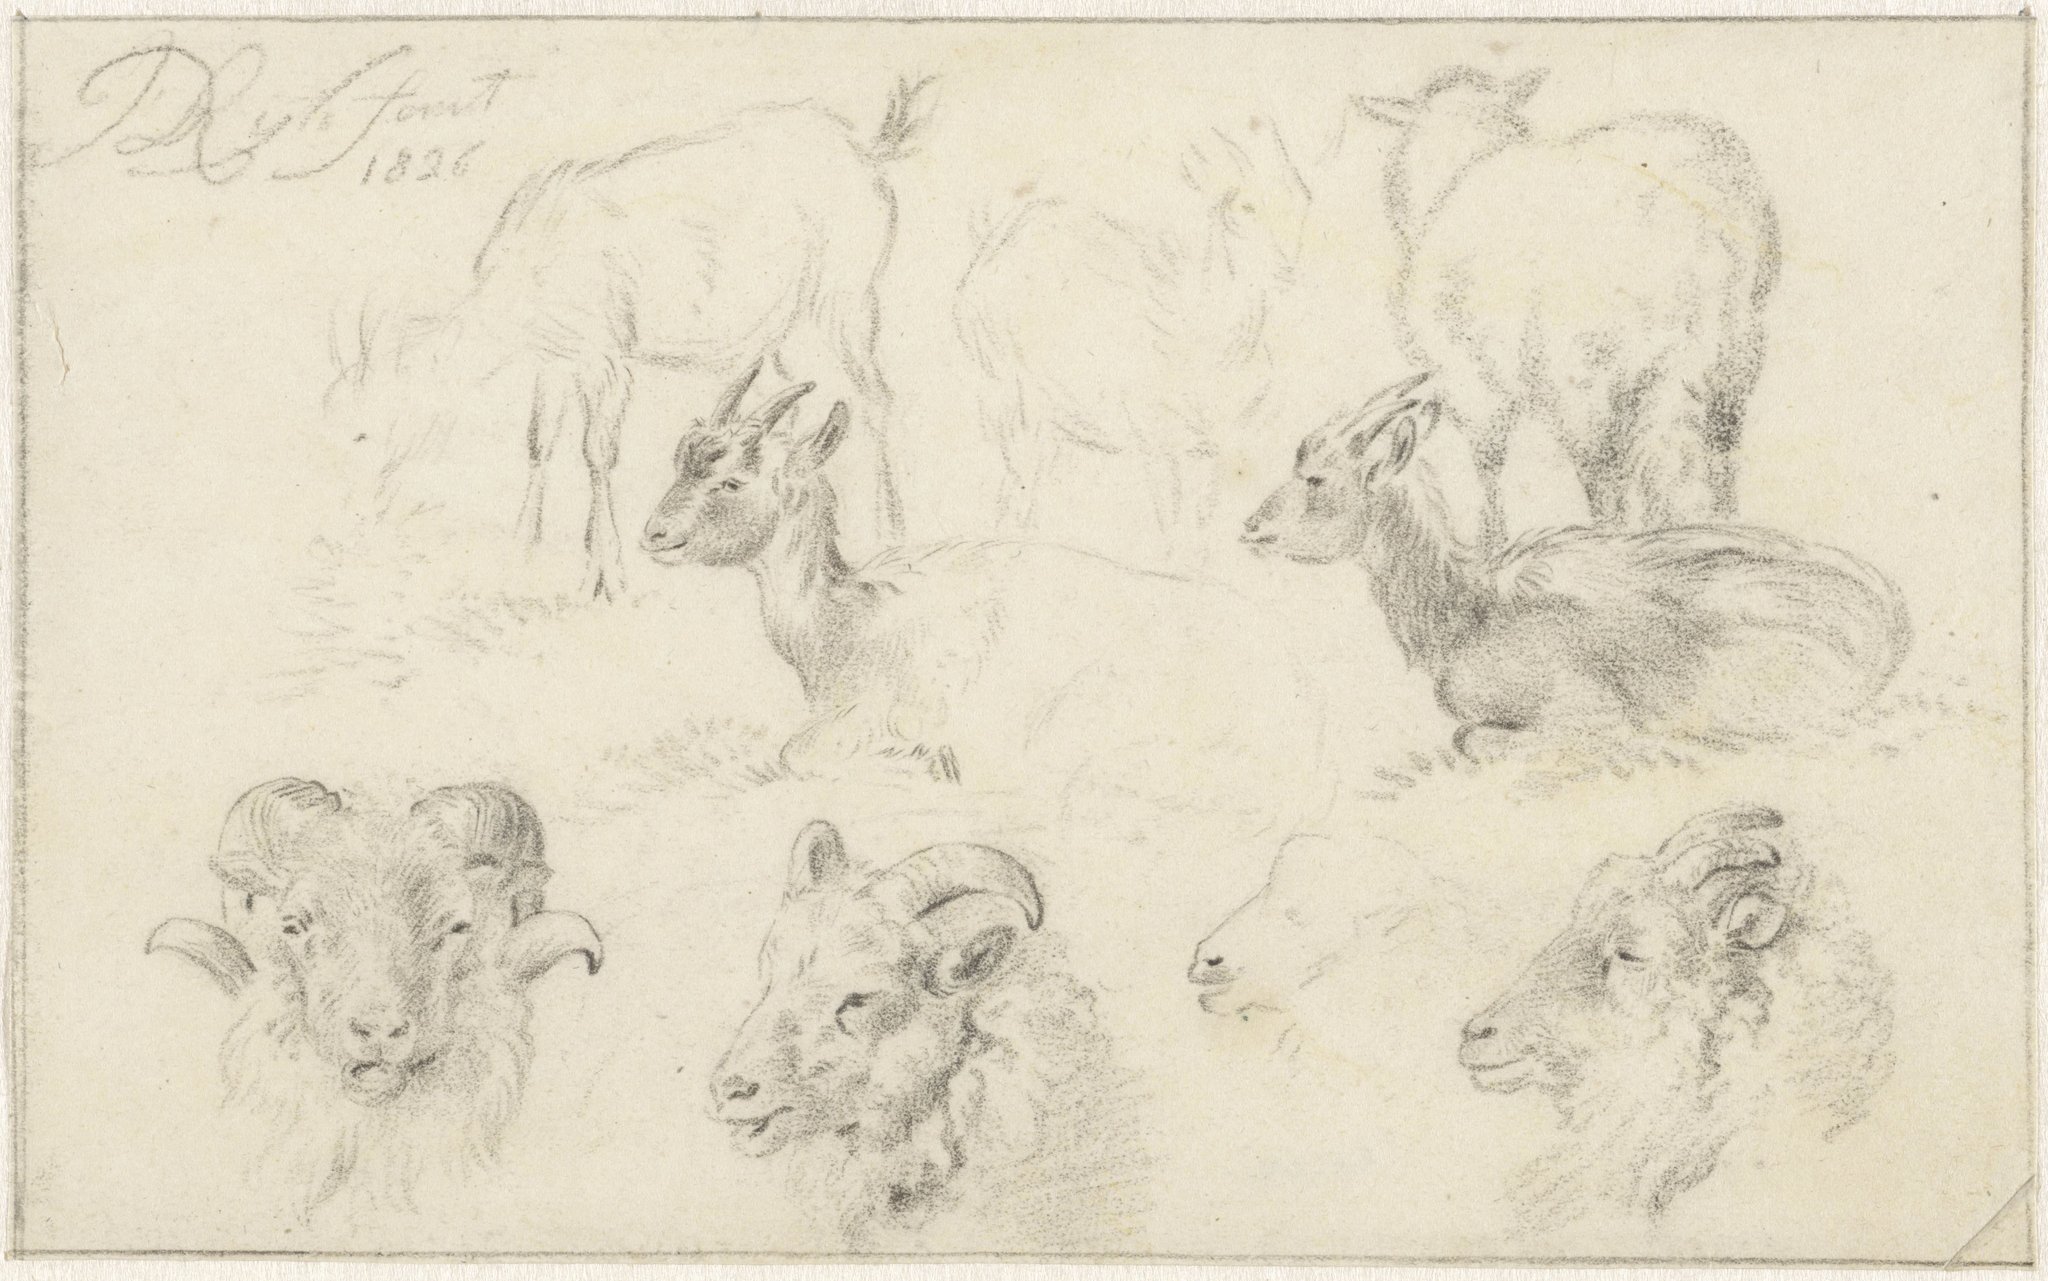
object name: drawing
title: Studies van schapen en geiten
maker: james de rijk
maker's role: draughtsman, painter, print maker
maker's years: 1806-1882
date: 1826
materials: chalk, paper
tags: sheep, goat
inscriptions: date: ‘1826’